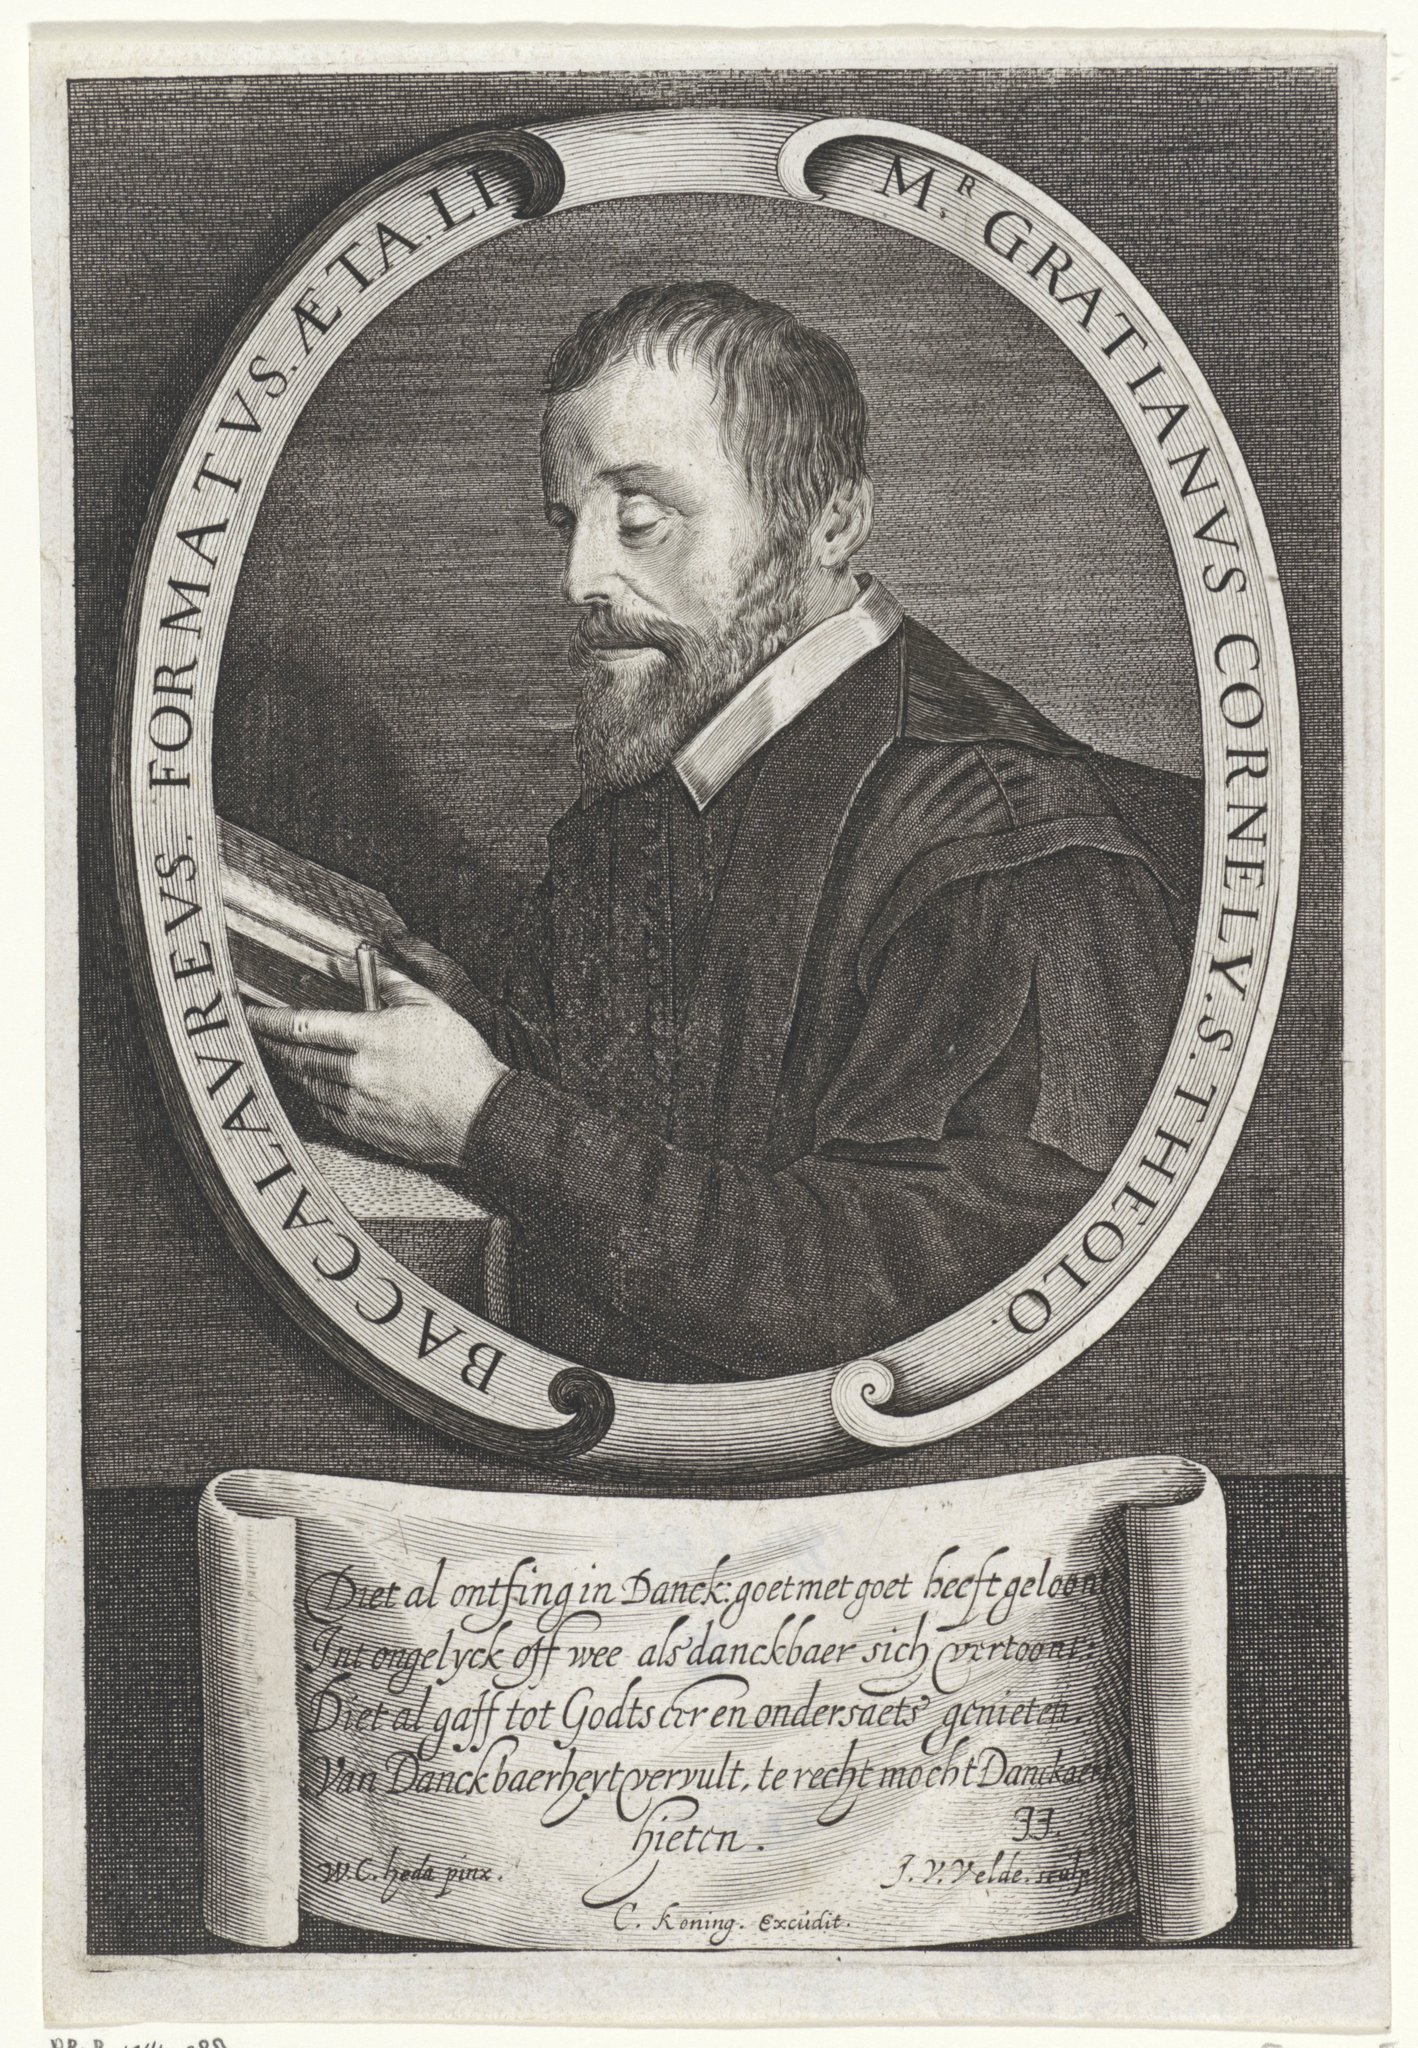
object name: print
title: Portret van Cornelis Danckaert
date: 1626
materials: paper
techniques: engraving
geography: northern netherlands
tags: cornelis danckaert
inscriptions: collector's mark: Lugt 2228, collector's mark: Lugt 2760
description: Portret van Cornelis Danckaert, rooms-katholiek geestelijke te Haarlem, op 51-jarige leeftijd.